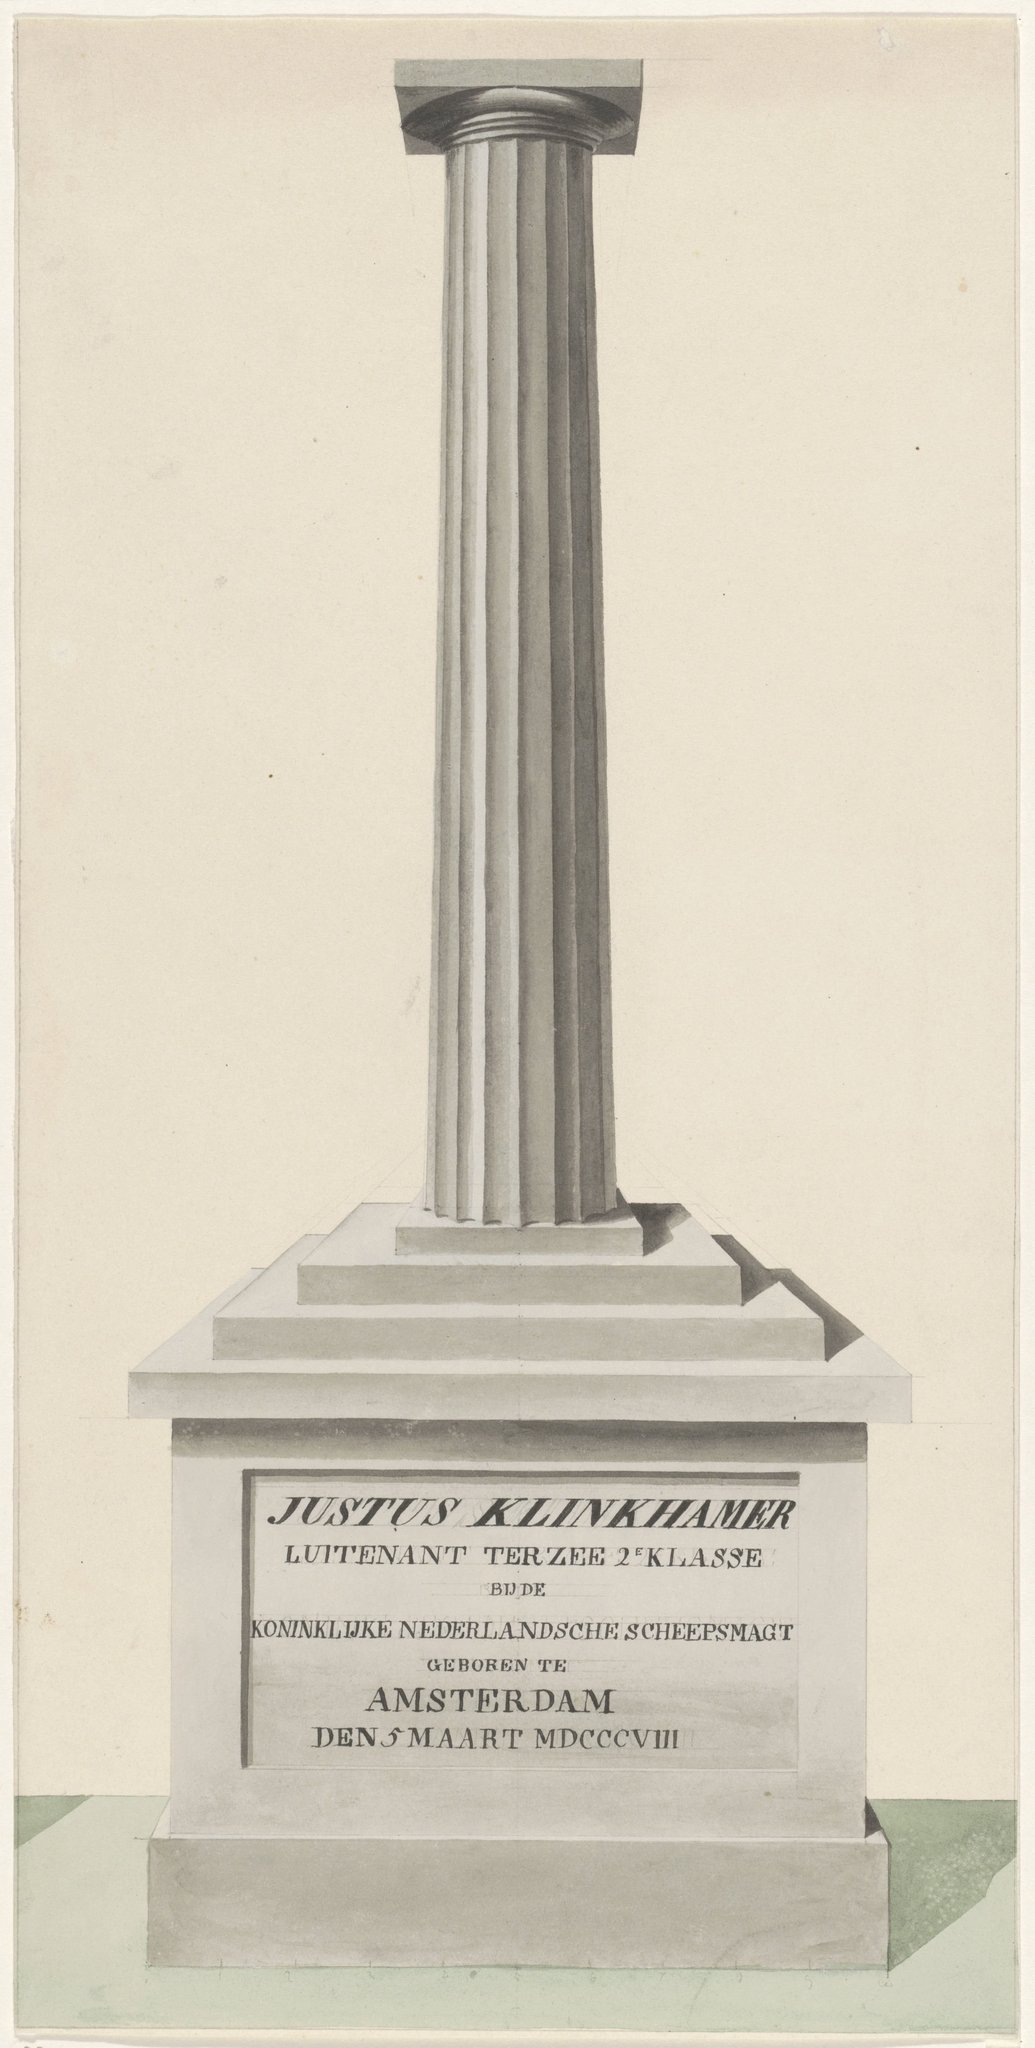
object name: drawing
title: Grafmonument voor Justus Klinkhamer, 1830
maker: Anonymous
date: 1830-1831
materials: paper, pencil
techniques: brush, pen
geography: netherlands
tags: amsterdam, grave, tomb, flushing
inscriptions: collector's mark: Lugt 2228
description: Het grafmonument voor Justus Klinkhamer op het kerkhof te Vlissingen. Klinkhamer, luitenant ter zee tweede klasse, raakte gewond tijdens het bombardement op Antwerpen op 27 oktober 1830 en stierf 2 dagen later. Het monument heeft de vorm van een zuil op een voetstuk. Bij de tekening horen twee bladen met de opschriften op het monument.